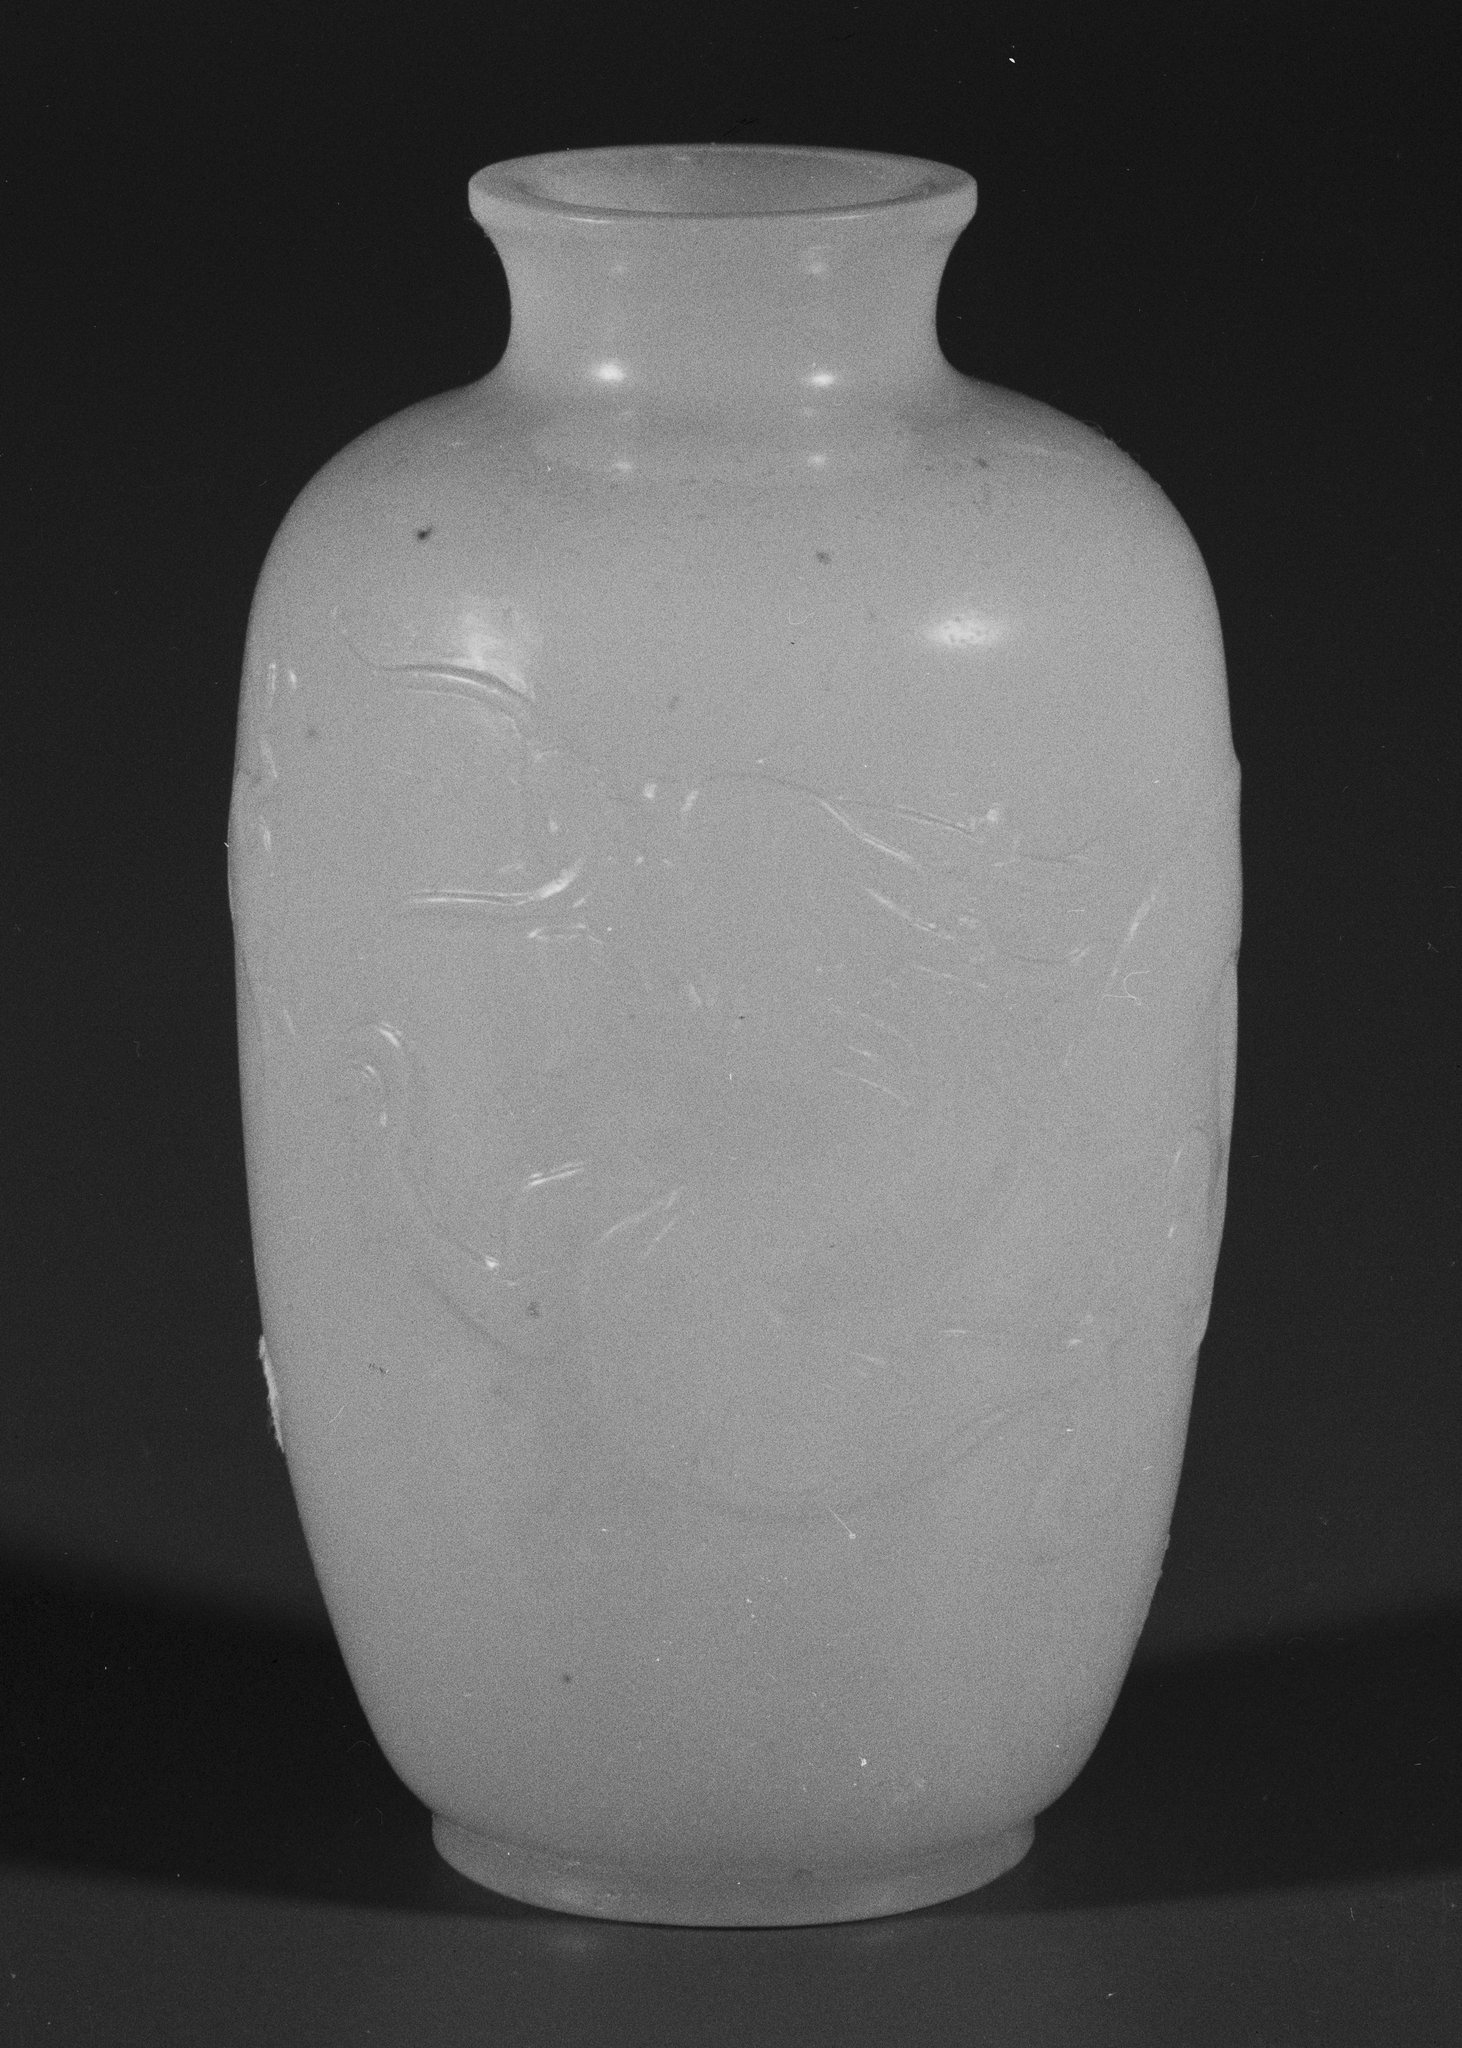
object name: vase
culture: chinese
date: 1701-1800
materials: jade